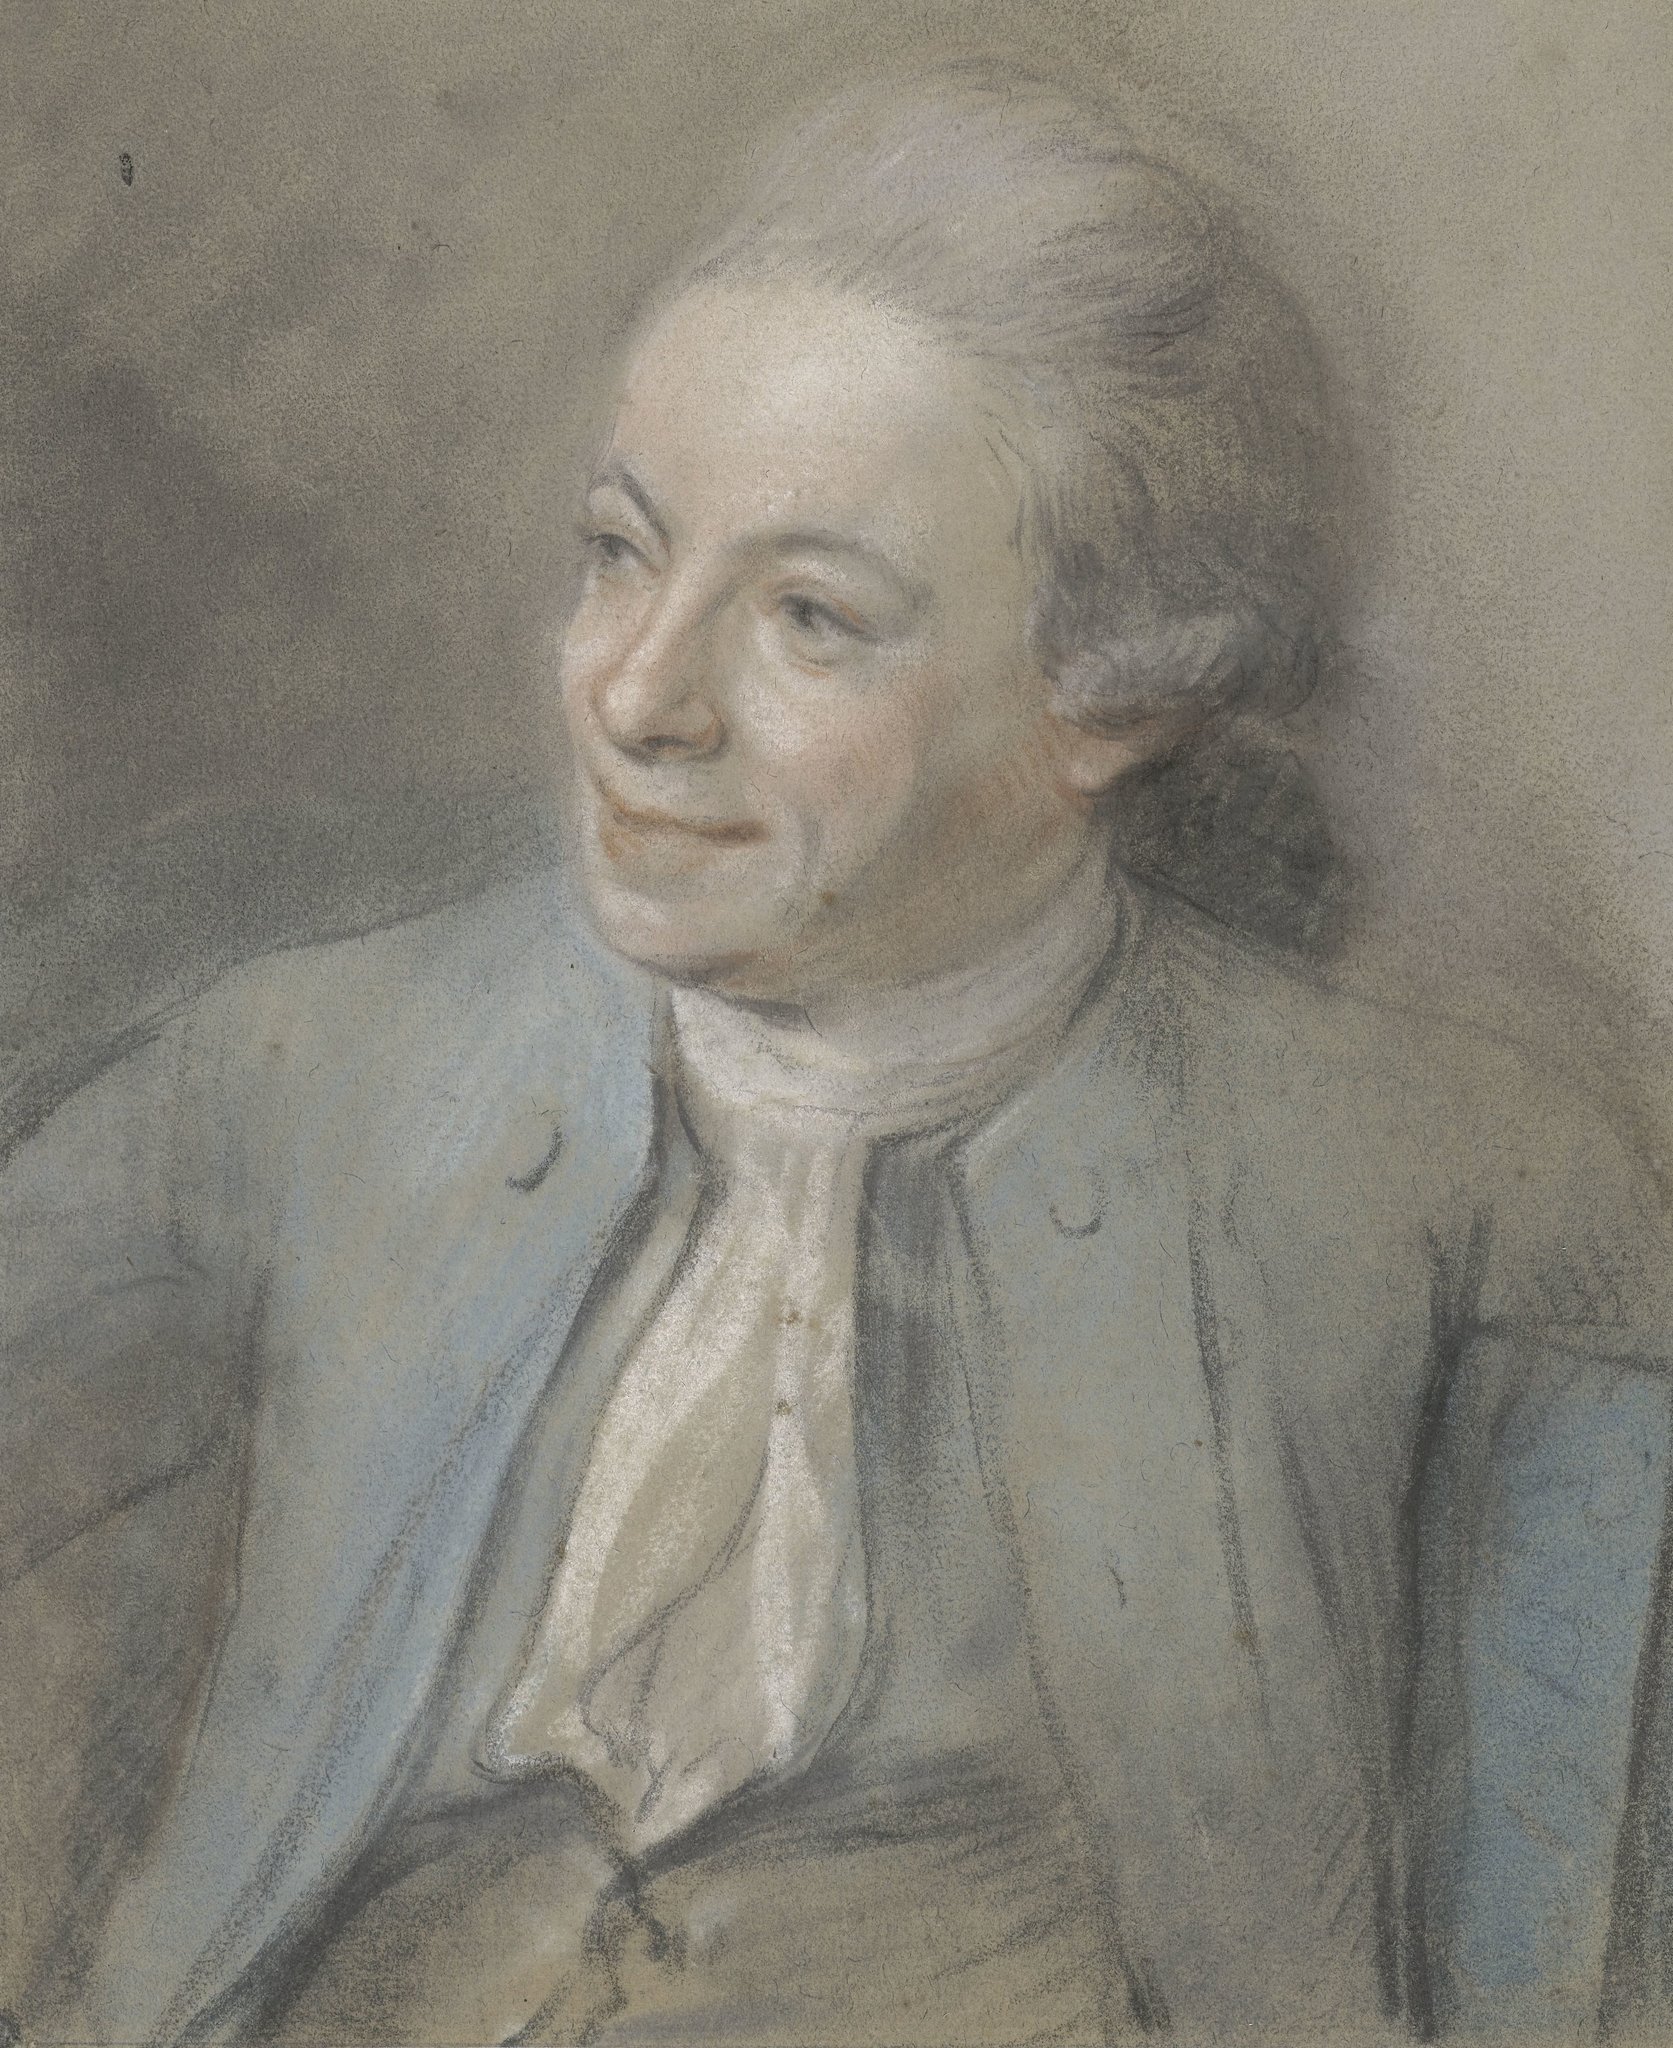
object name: drawing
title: Portret van Dirk Versteegh, ten halven lijve, naar links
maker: jurriaan andriessen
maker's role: draughtsman, painter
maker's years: 1742-1819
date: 1772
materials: paper, pastel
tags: amsterdam, draughtsman, dirk versteegh, historical persons, portrait, self-portrait of artist, portrait, self-portrait of draughtsman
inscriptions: signature and date: ‘J. Andriessen del ad viv 1772’, inscription: ‘'t Portrait van DV oud 21 Jaaren Aº 1772 Jur.n Andriessen’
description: Jurriaan Andriessen (1742 - 1819). Dirk Versteegh (1751 - 1822), Amsterdam art collector, patron and amateur draughtsman, 1772 A. Allebé bequest, Amsterdam, 1927.